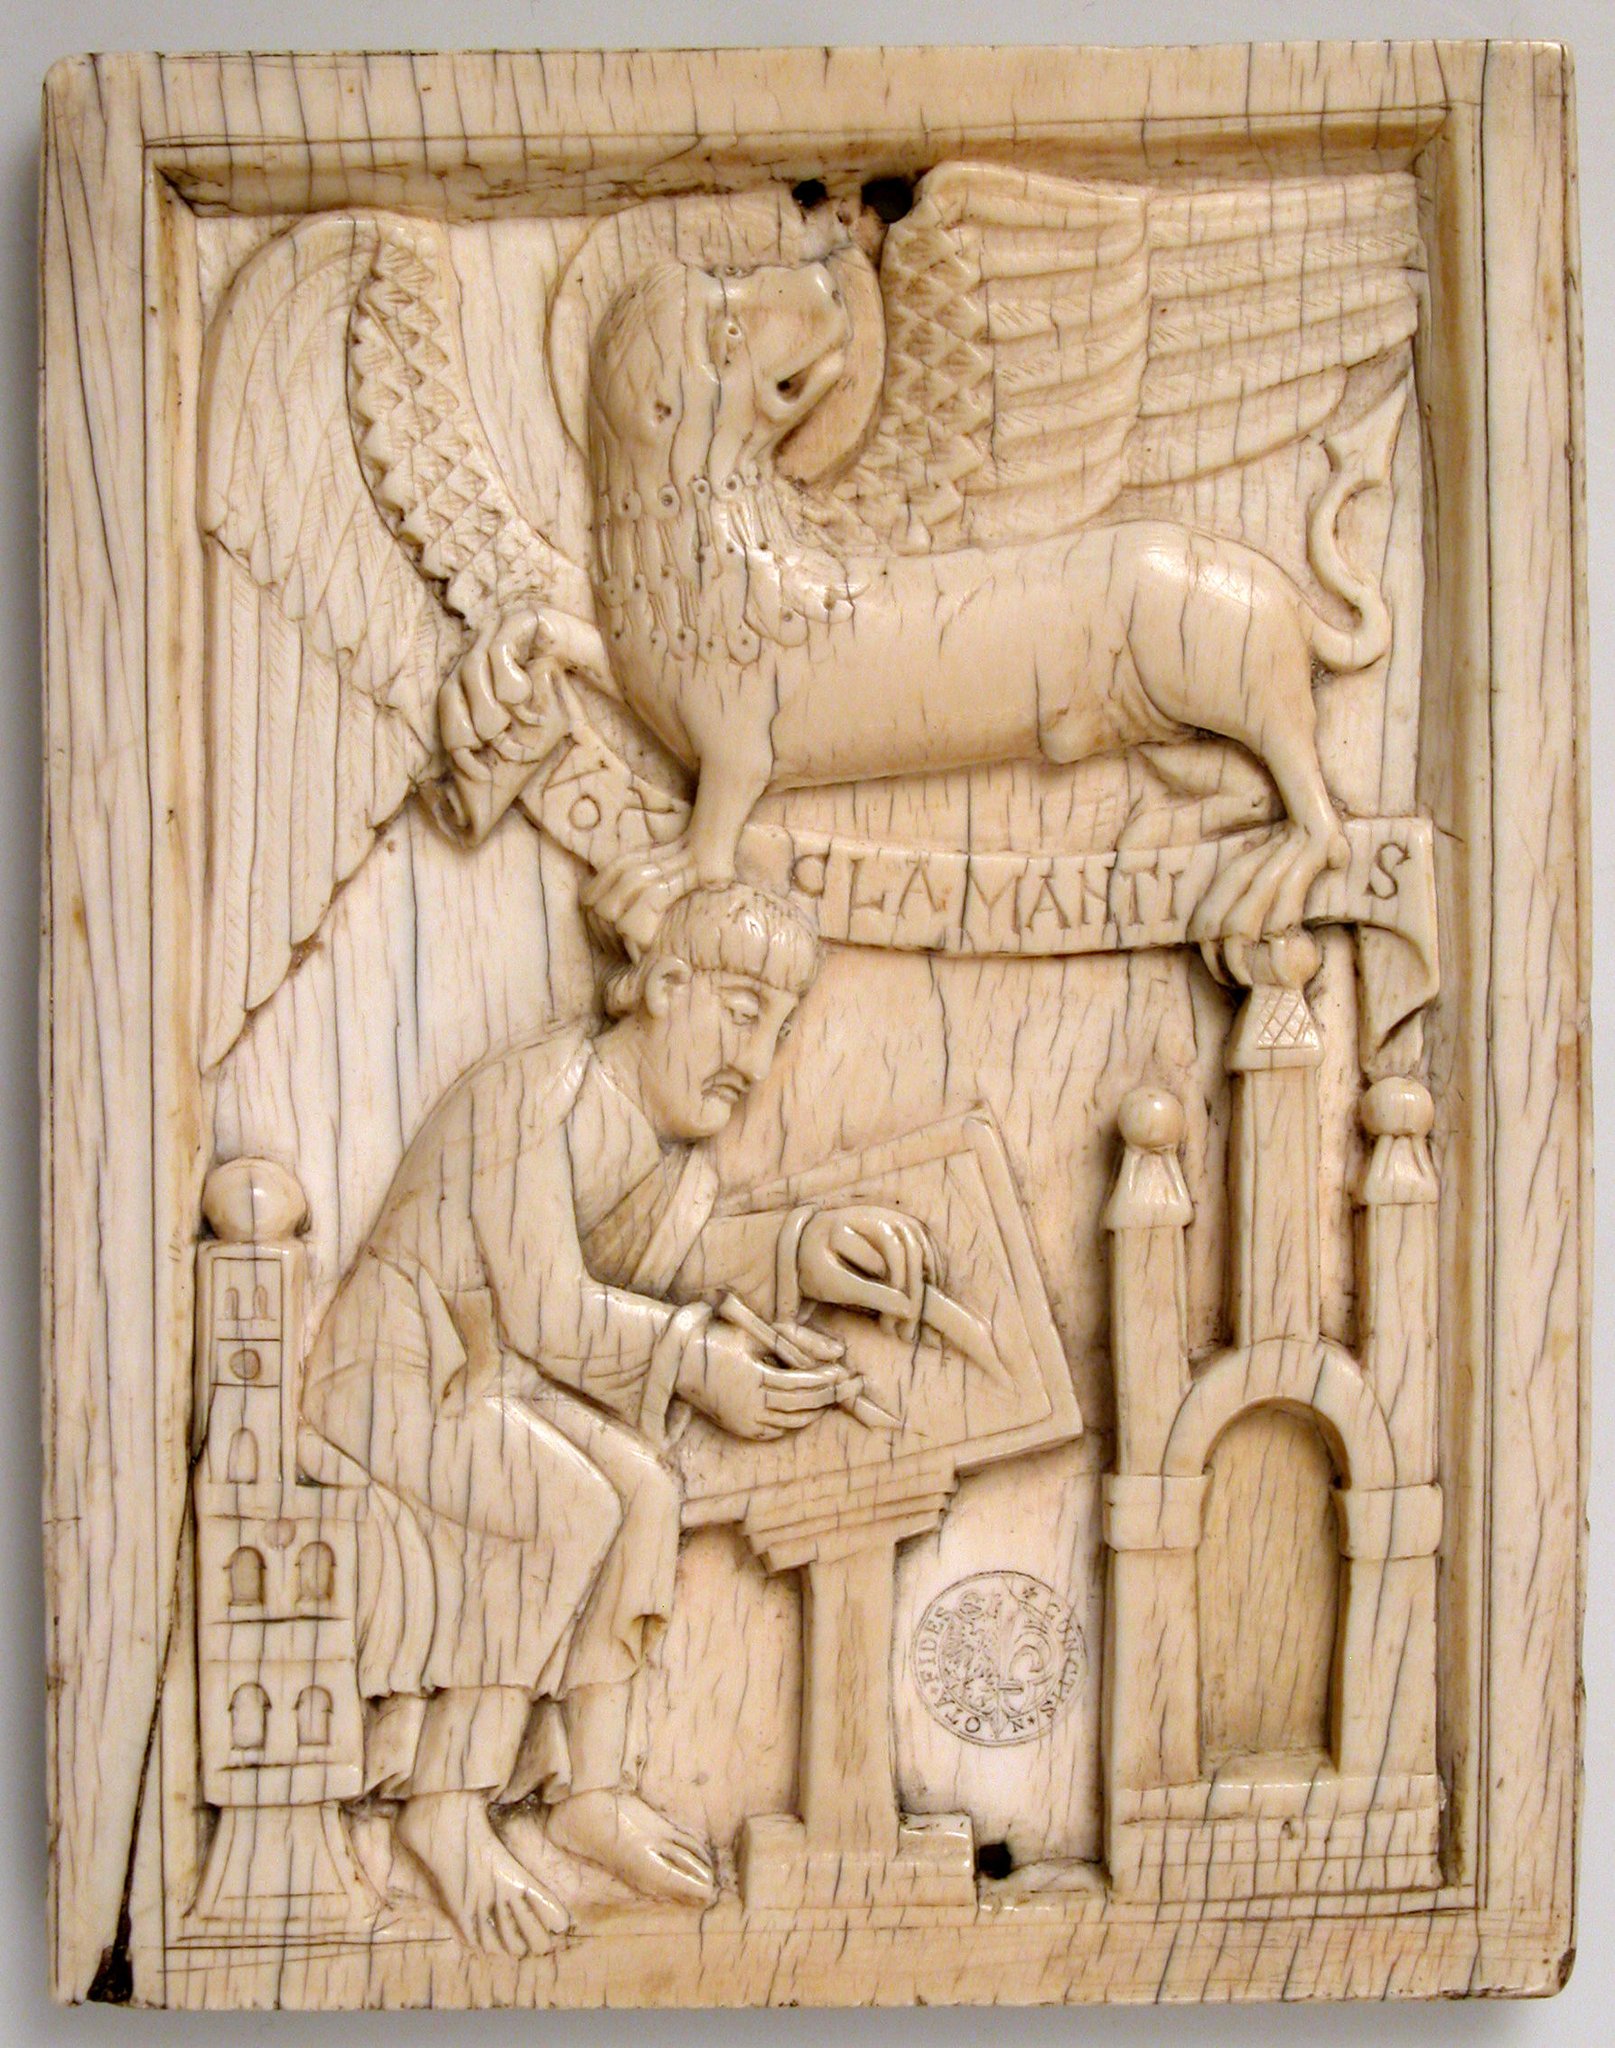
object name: plaque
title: Evangelist Saint Mark writing the Gospel with his symbol, the Lion, holding a scroll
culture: german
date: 1001-1100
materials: ivory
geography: germany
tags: lions,saint mark,writing,desks